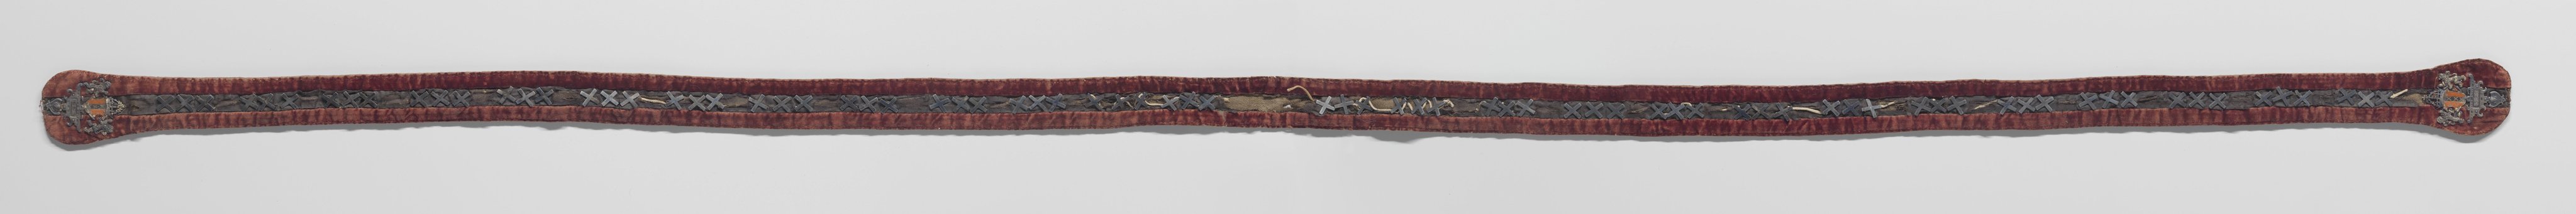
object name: bloedband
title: Bloedband van fluweel met aan beide uiteinden het wapen van Amsterdam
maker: Anonymous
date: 1595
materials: silver, velvet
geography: netherlands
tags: coat of arms (as symbol of the state, etc.) (+ city; municipal), amsterdam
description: Bloedband van rood en zwart fluweel, waarop aan beide uiteinden het Amsterdamse wapen is bevestigd, zwart en rood geëmailleerd en met verguld zilveren kroon en dito leeuwen. Onder deze wapens zilveren, gedeeltelijk vergulde cartouches waarin het jaartal 1595. Op de band zijn zesentwintig maal en éénmaal één kruisje van zilver aangebracht.